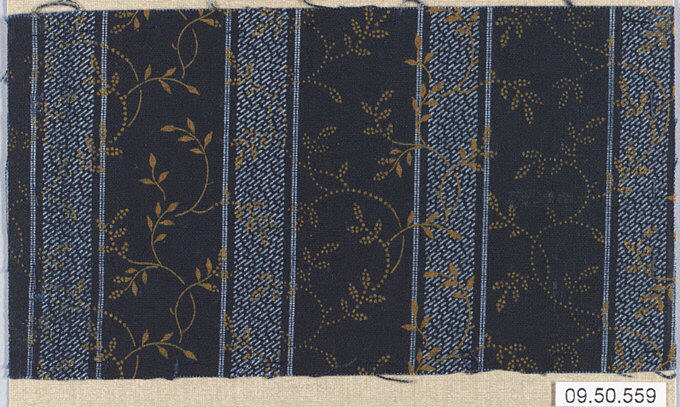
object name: piece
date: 1801-1900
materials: cotton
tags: leaves